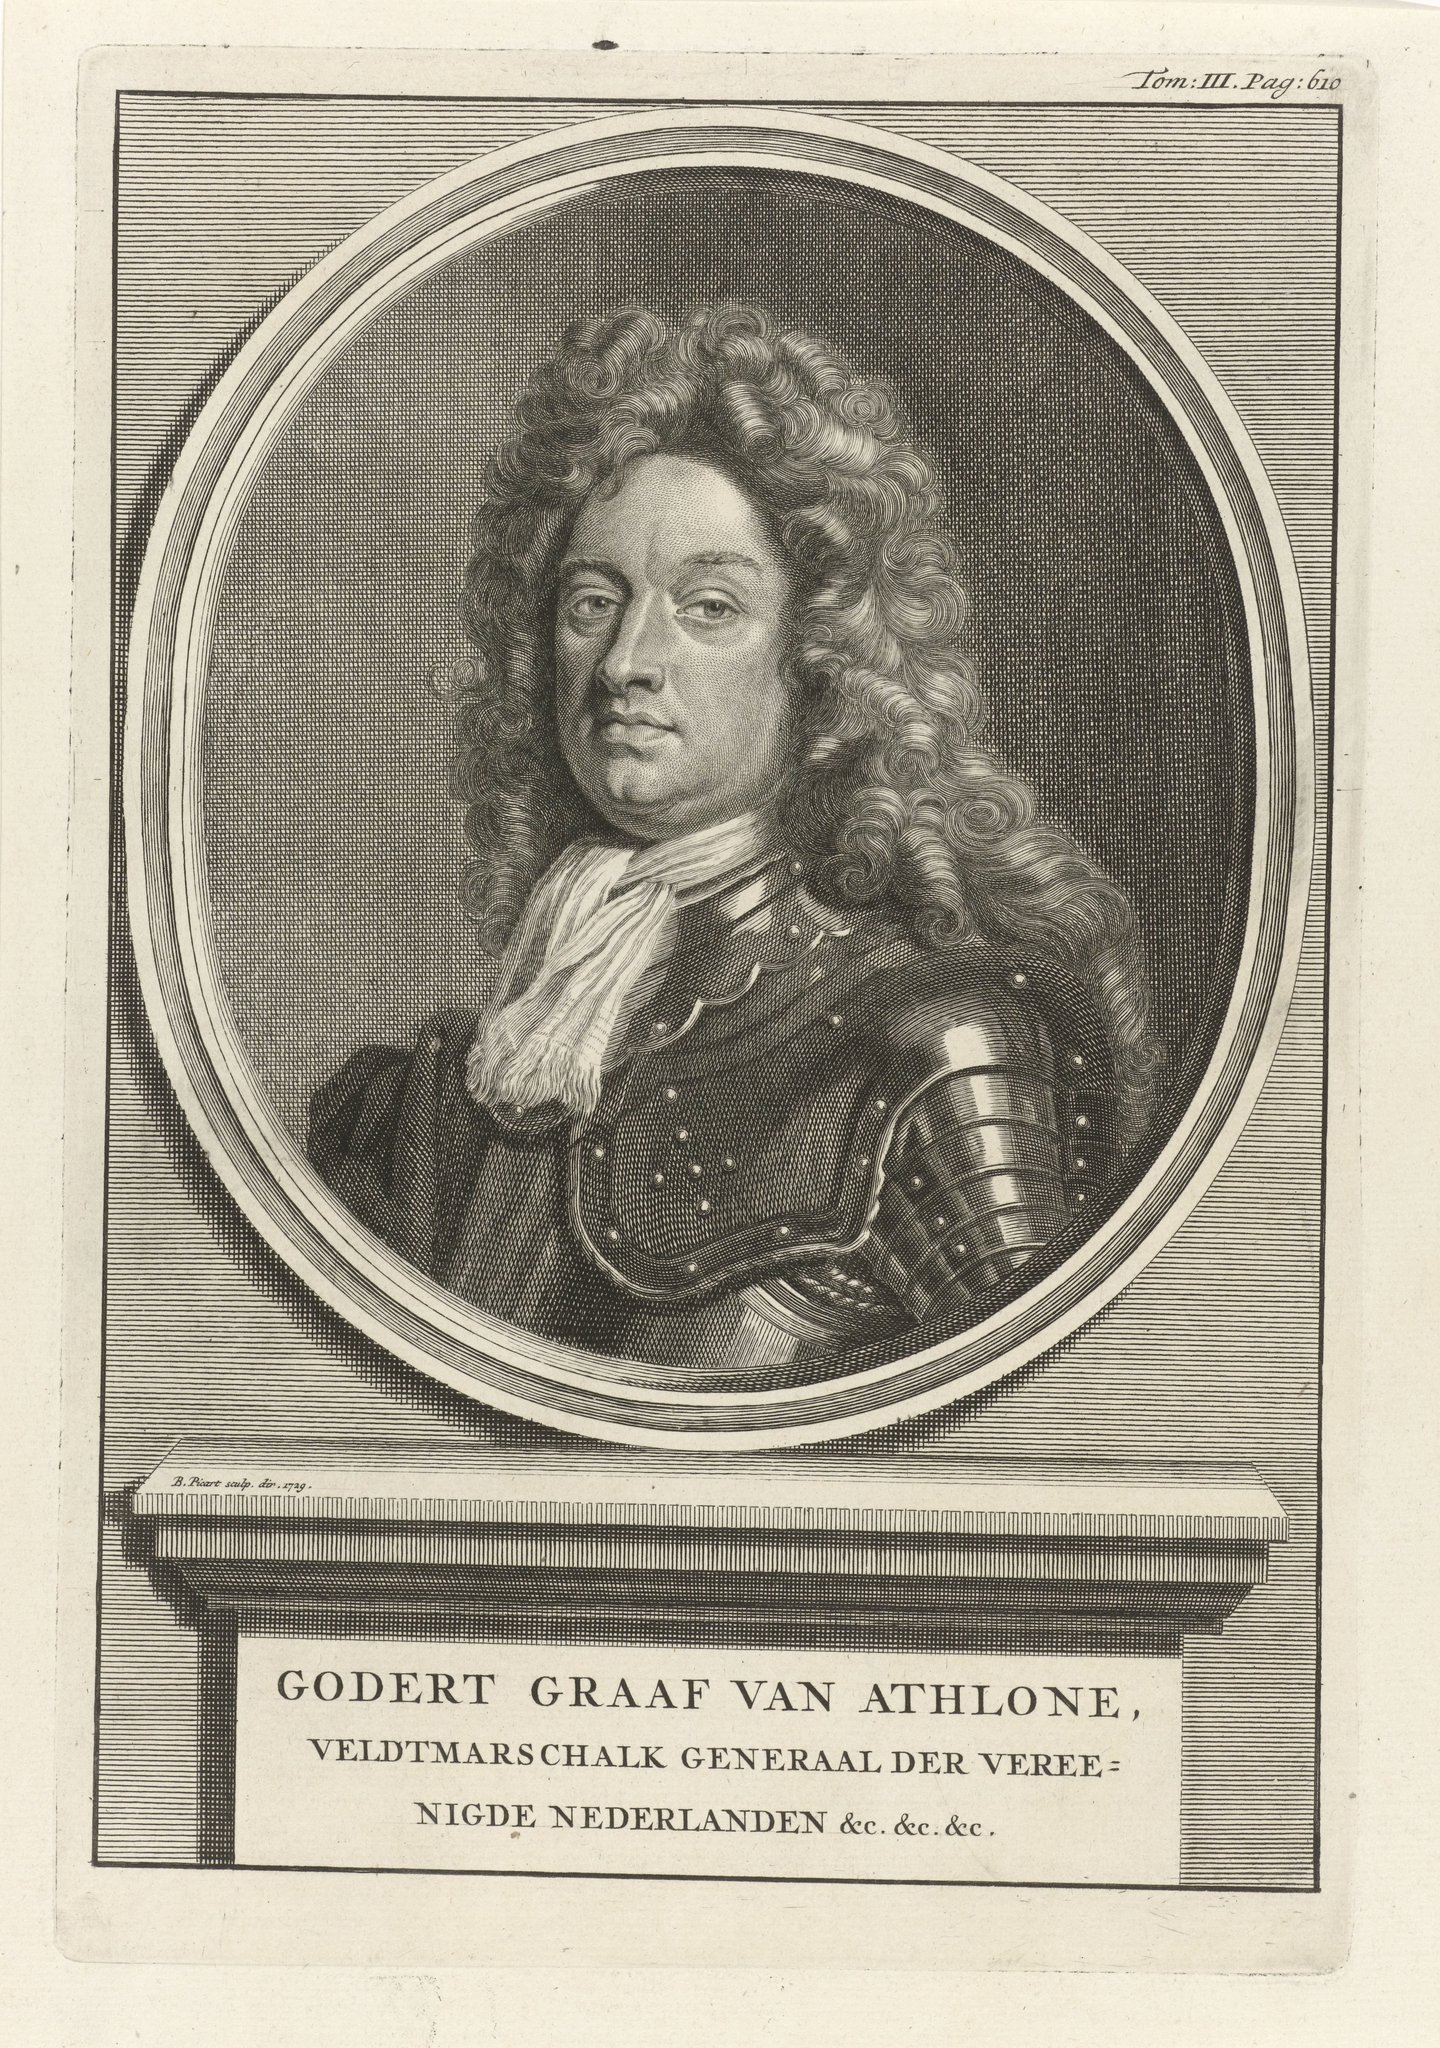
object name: book illustration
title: Portret van Godard, baron van Reede-Ginckel, graaf van Athlone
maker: bernard picart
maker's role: draughtsman, print maker, publisher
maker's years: 1673-1733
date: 1729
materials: paper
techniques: engraving, etching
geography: amsterdam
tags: utrecht, godard baron van reede-ginckel (graaf van athlone), armour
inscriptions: collector's mark: Lugt 2228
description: Prent als illustratie gebruikt in: Le Clerc, Jean. Geschiedenissen der Vereenigde Nederlanden. Amsterdam: Zacharias Chatelain (II), 1730.